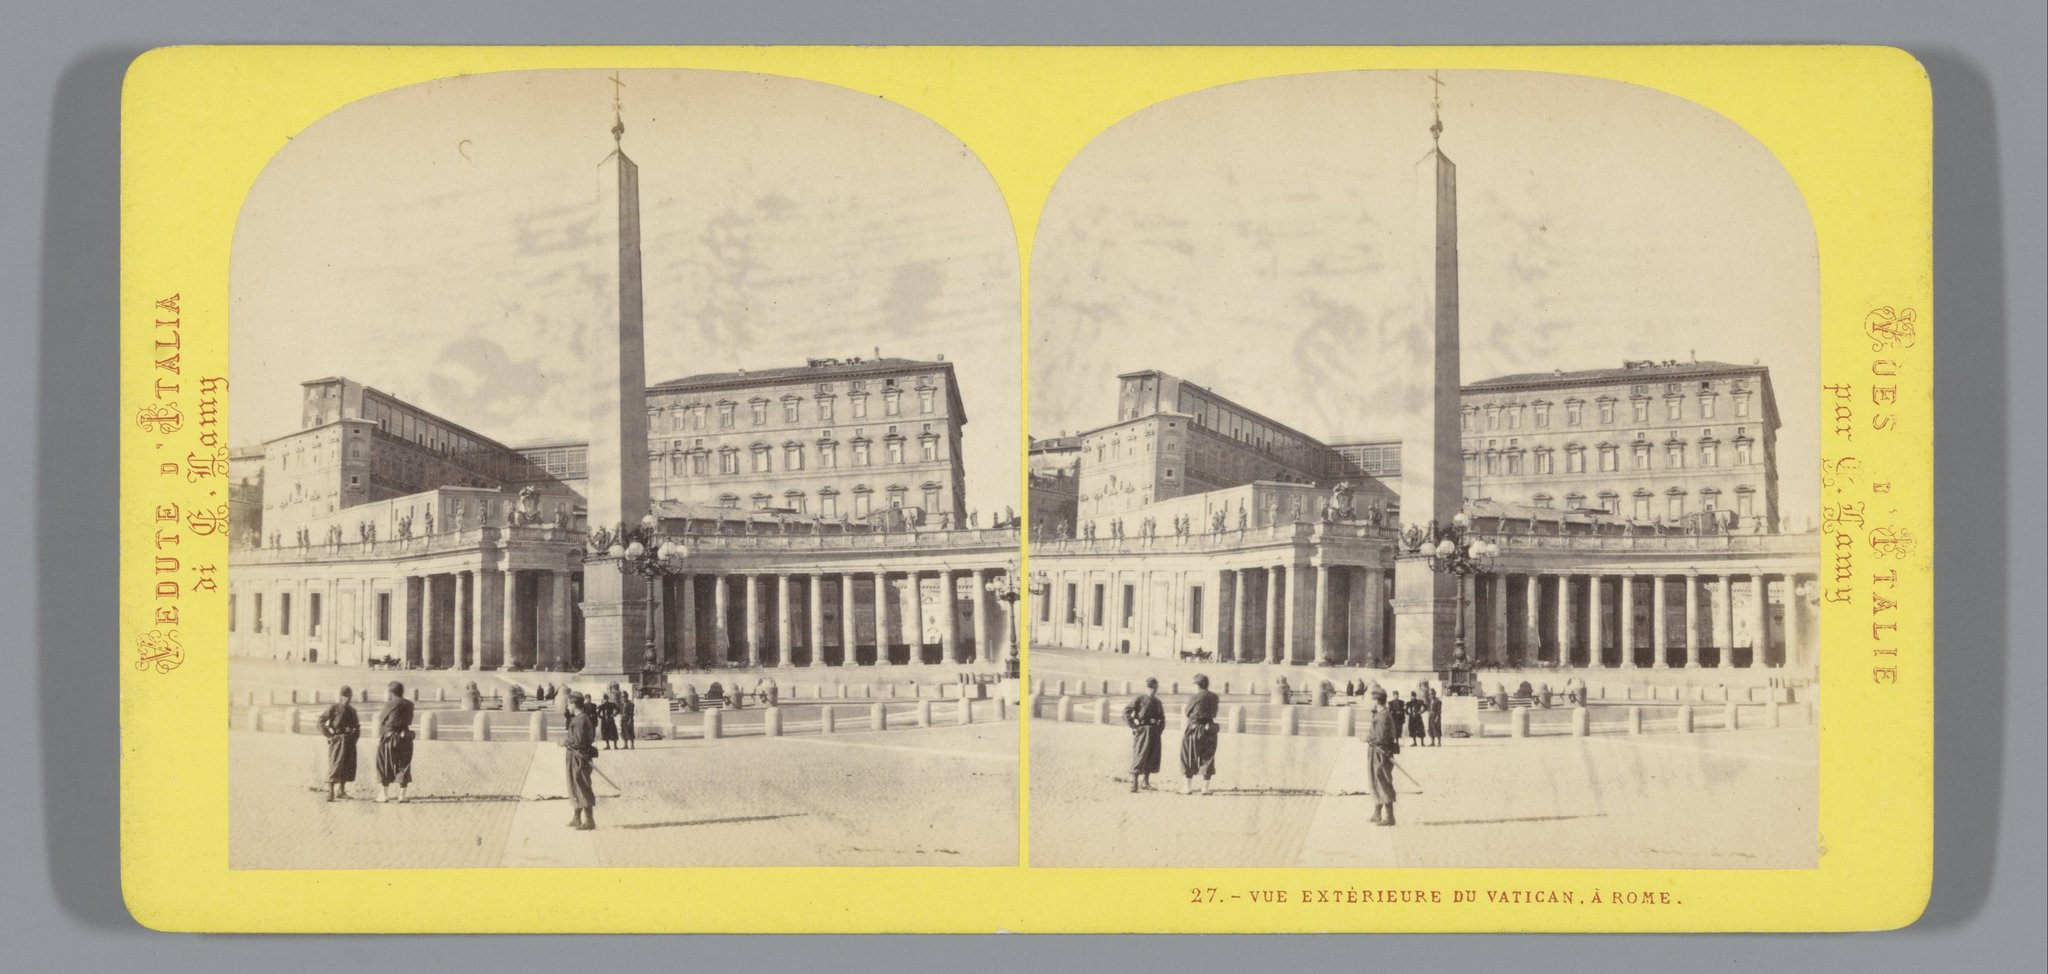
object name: stereograph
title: Vedute d'Italia / Vues d'Italie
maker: ernest eléonor pierre lamy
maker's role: publisher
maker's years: 1828-1900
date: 1861-1878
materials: cardboard, paper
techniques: albumen print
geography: vatican city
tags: obelisk, needle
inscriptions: number: ‘27.’